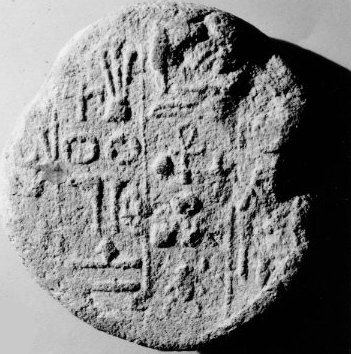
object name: cone, circular impression, menkheperresonb, double granary, amun, thutmose iii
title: Funerary Cone of the Overseer of the Double Granary Menkheperresonb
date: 1479-1425 BCE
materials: pottery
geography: egypt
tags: hieroglyphs